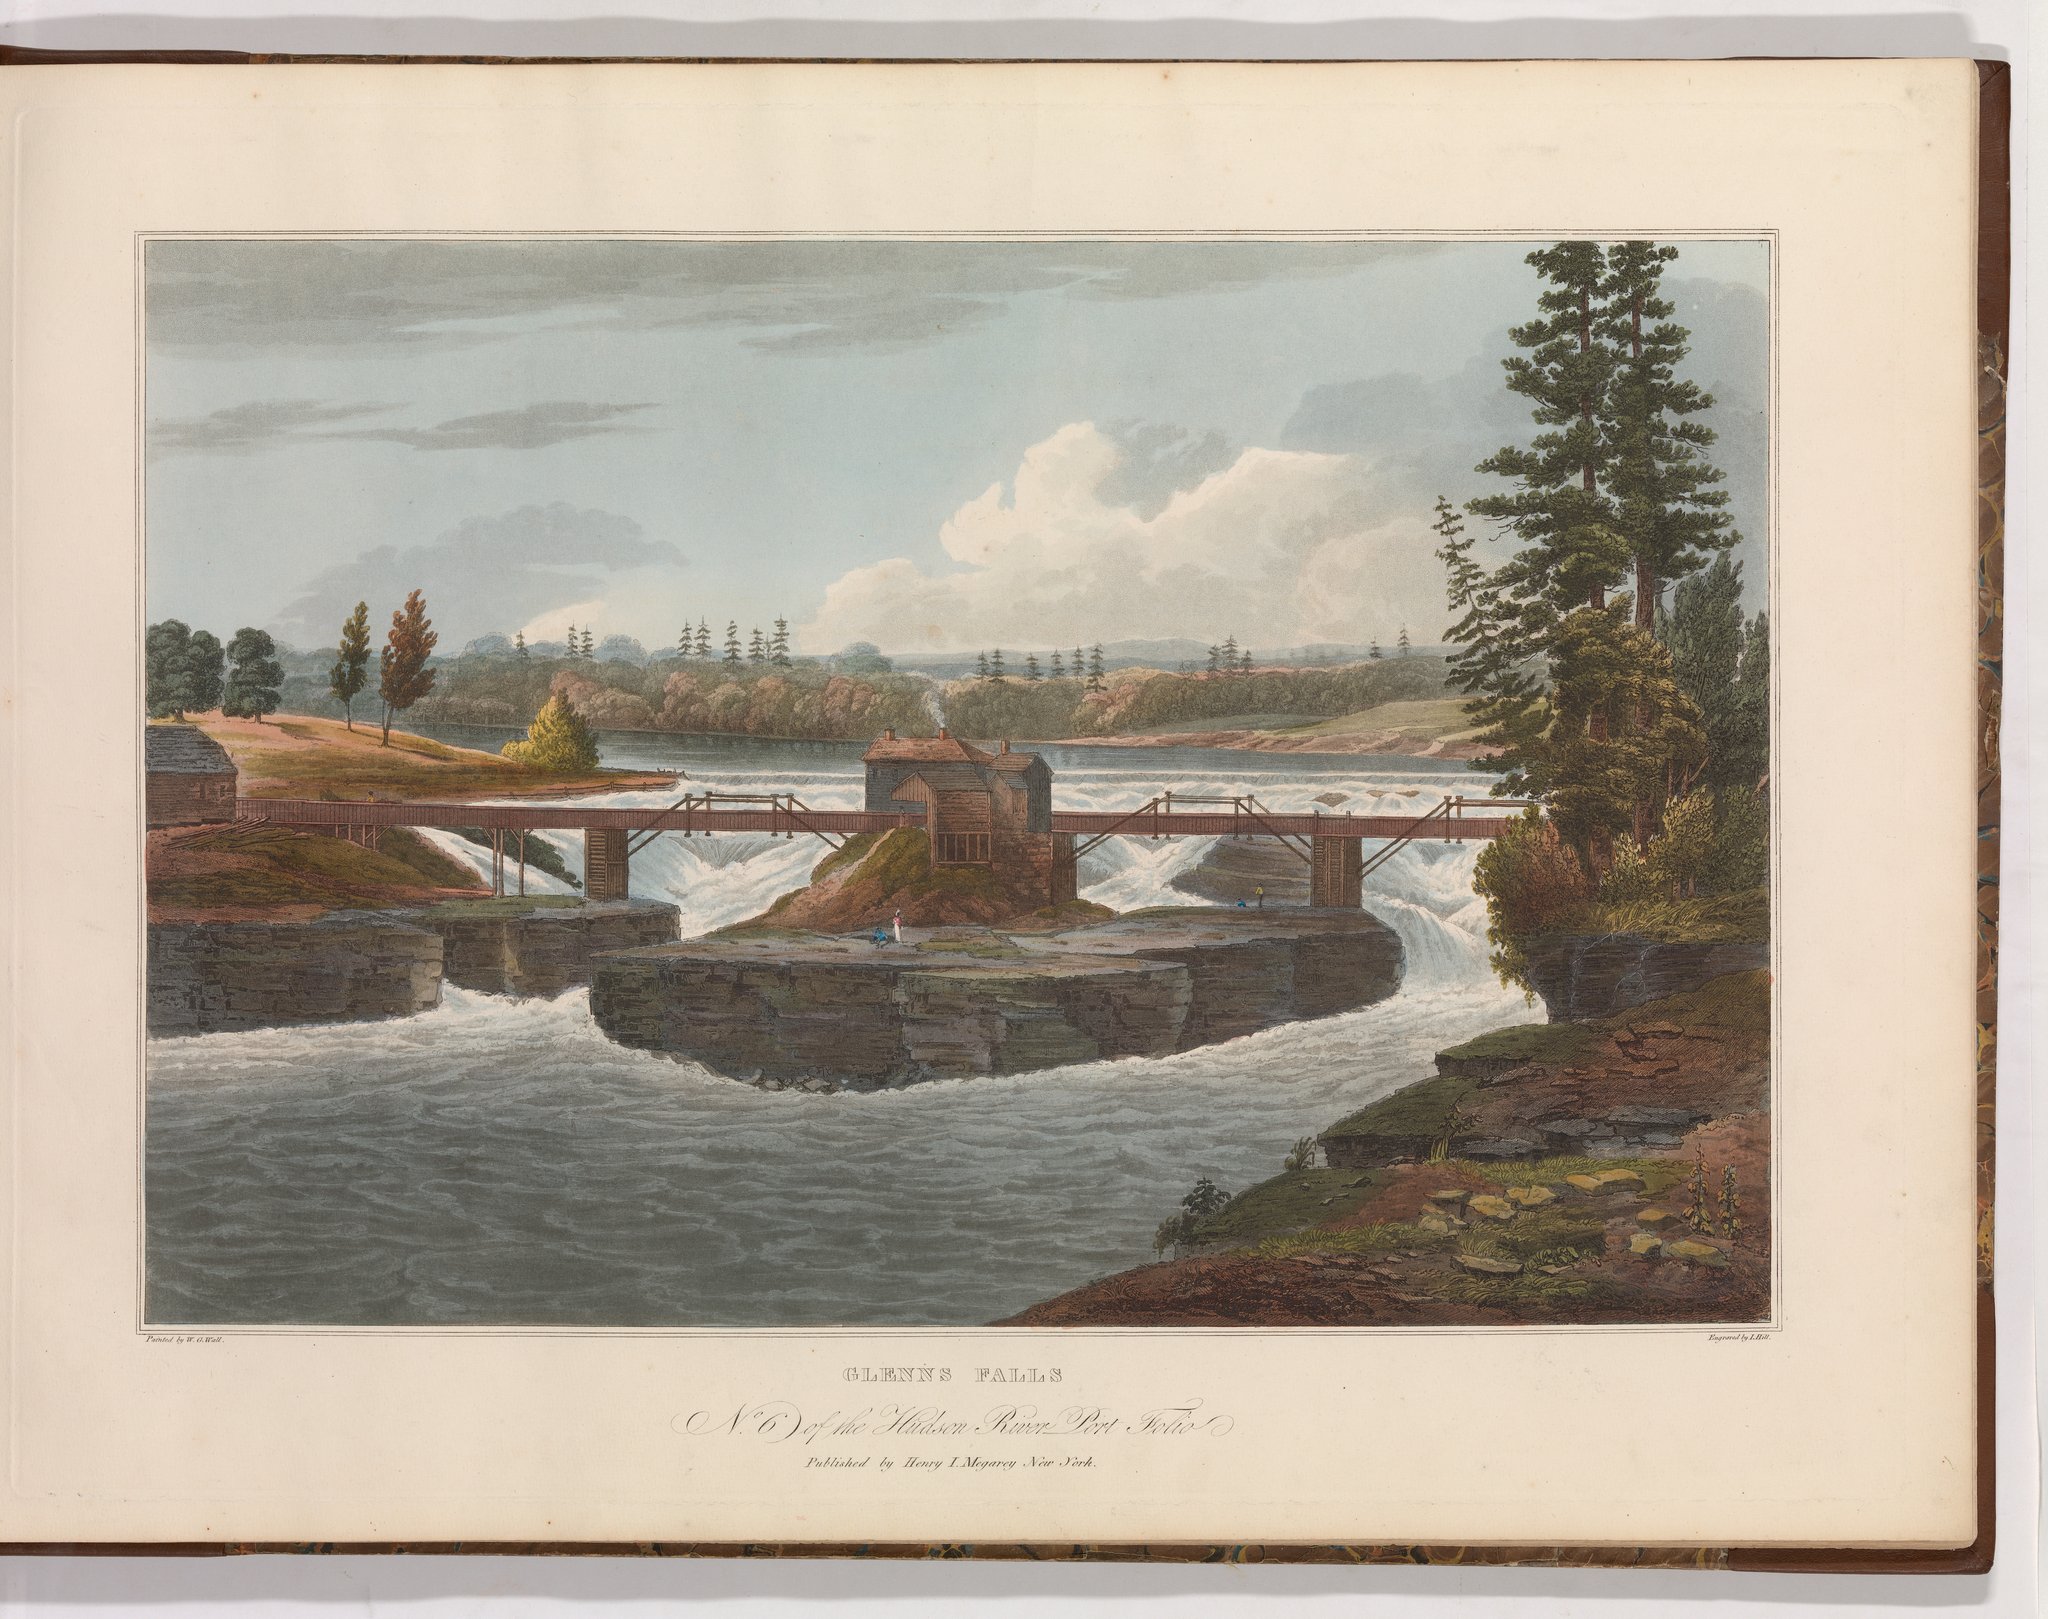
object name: print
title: Glenns Falls (No. 6 of The Hudson River Portfolio)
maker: john hill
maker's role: etcher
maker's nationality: american, born england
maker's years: 1770-1850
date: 1822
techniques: aquatint, hand coloring, printing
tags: houses,bridges,rivers,waterfalls,trees